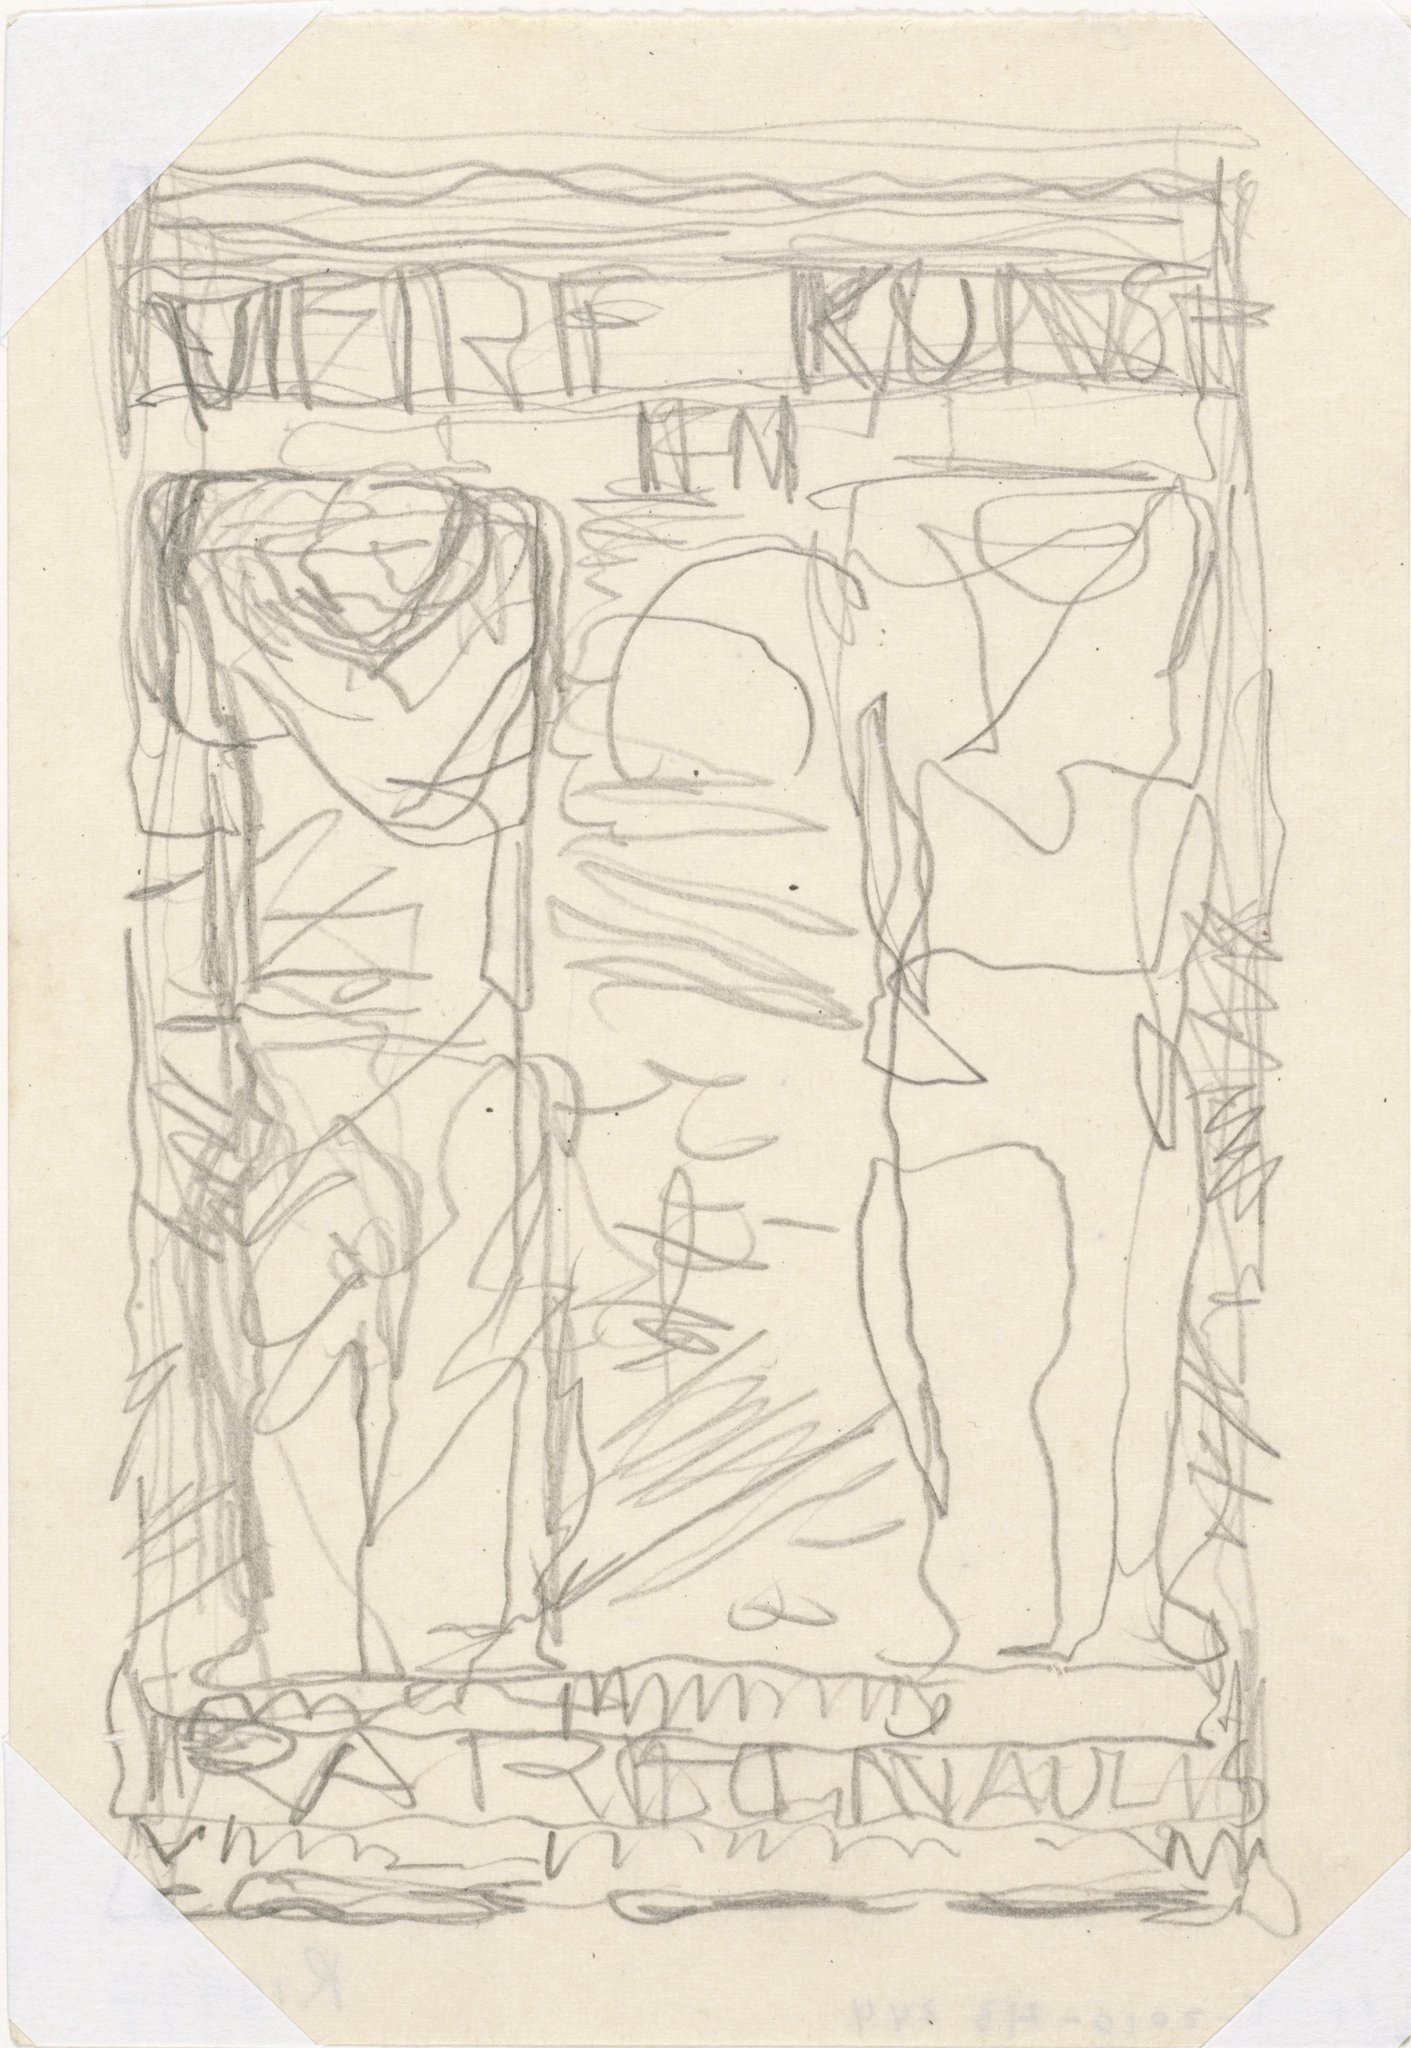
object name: drawing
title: Zonder titel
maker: leo gestel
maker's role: draughtsman, print maker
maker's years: 1881-1941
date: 1931-1941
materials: paper, pencil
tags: painting (including book-illumination, miniature-painting)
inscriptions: title: ‘VERF EN KUNST // [onleesbaar]’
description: Twee erecte figuren links en rechts, frontaal, het hoofd gebogen.